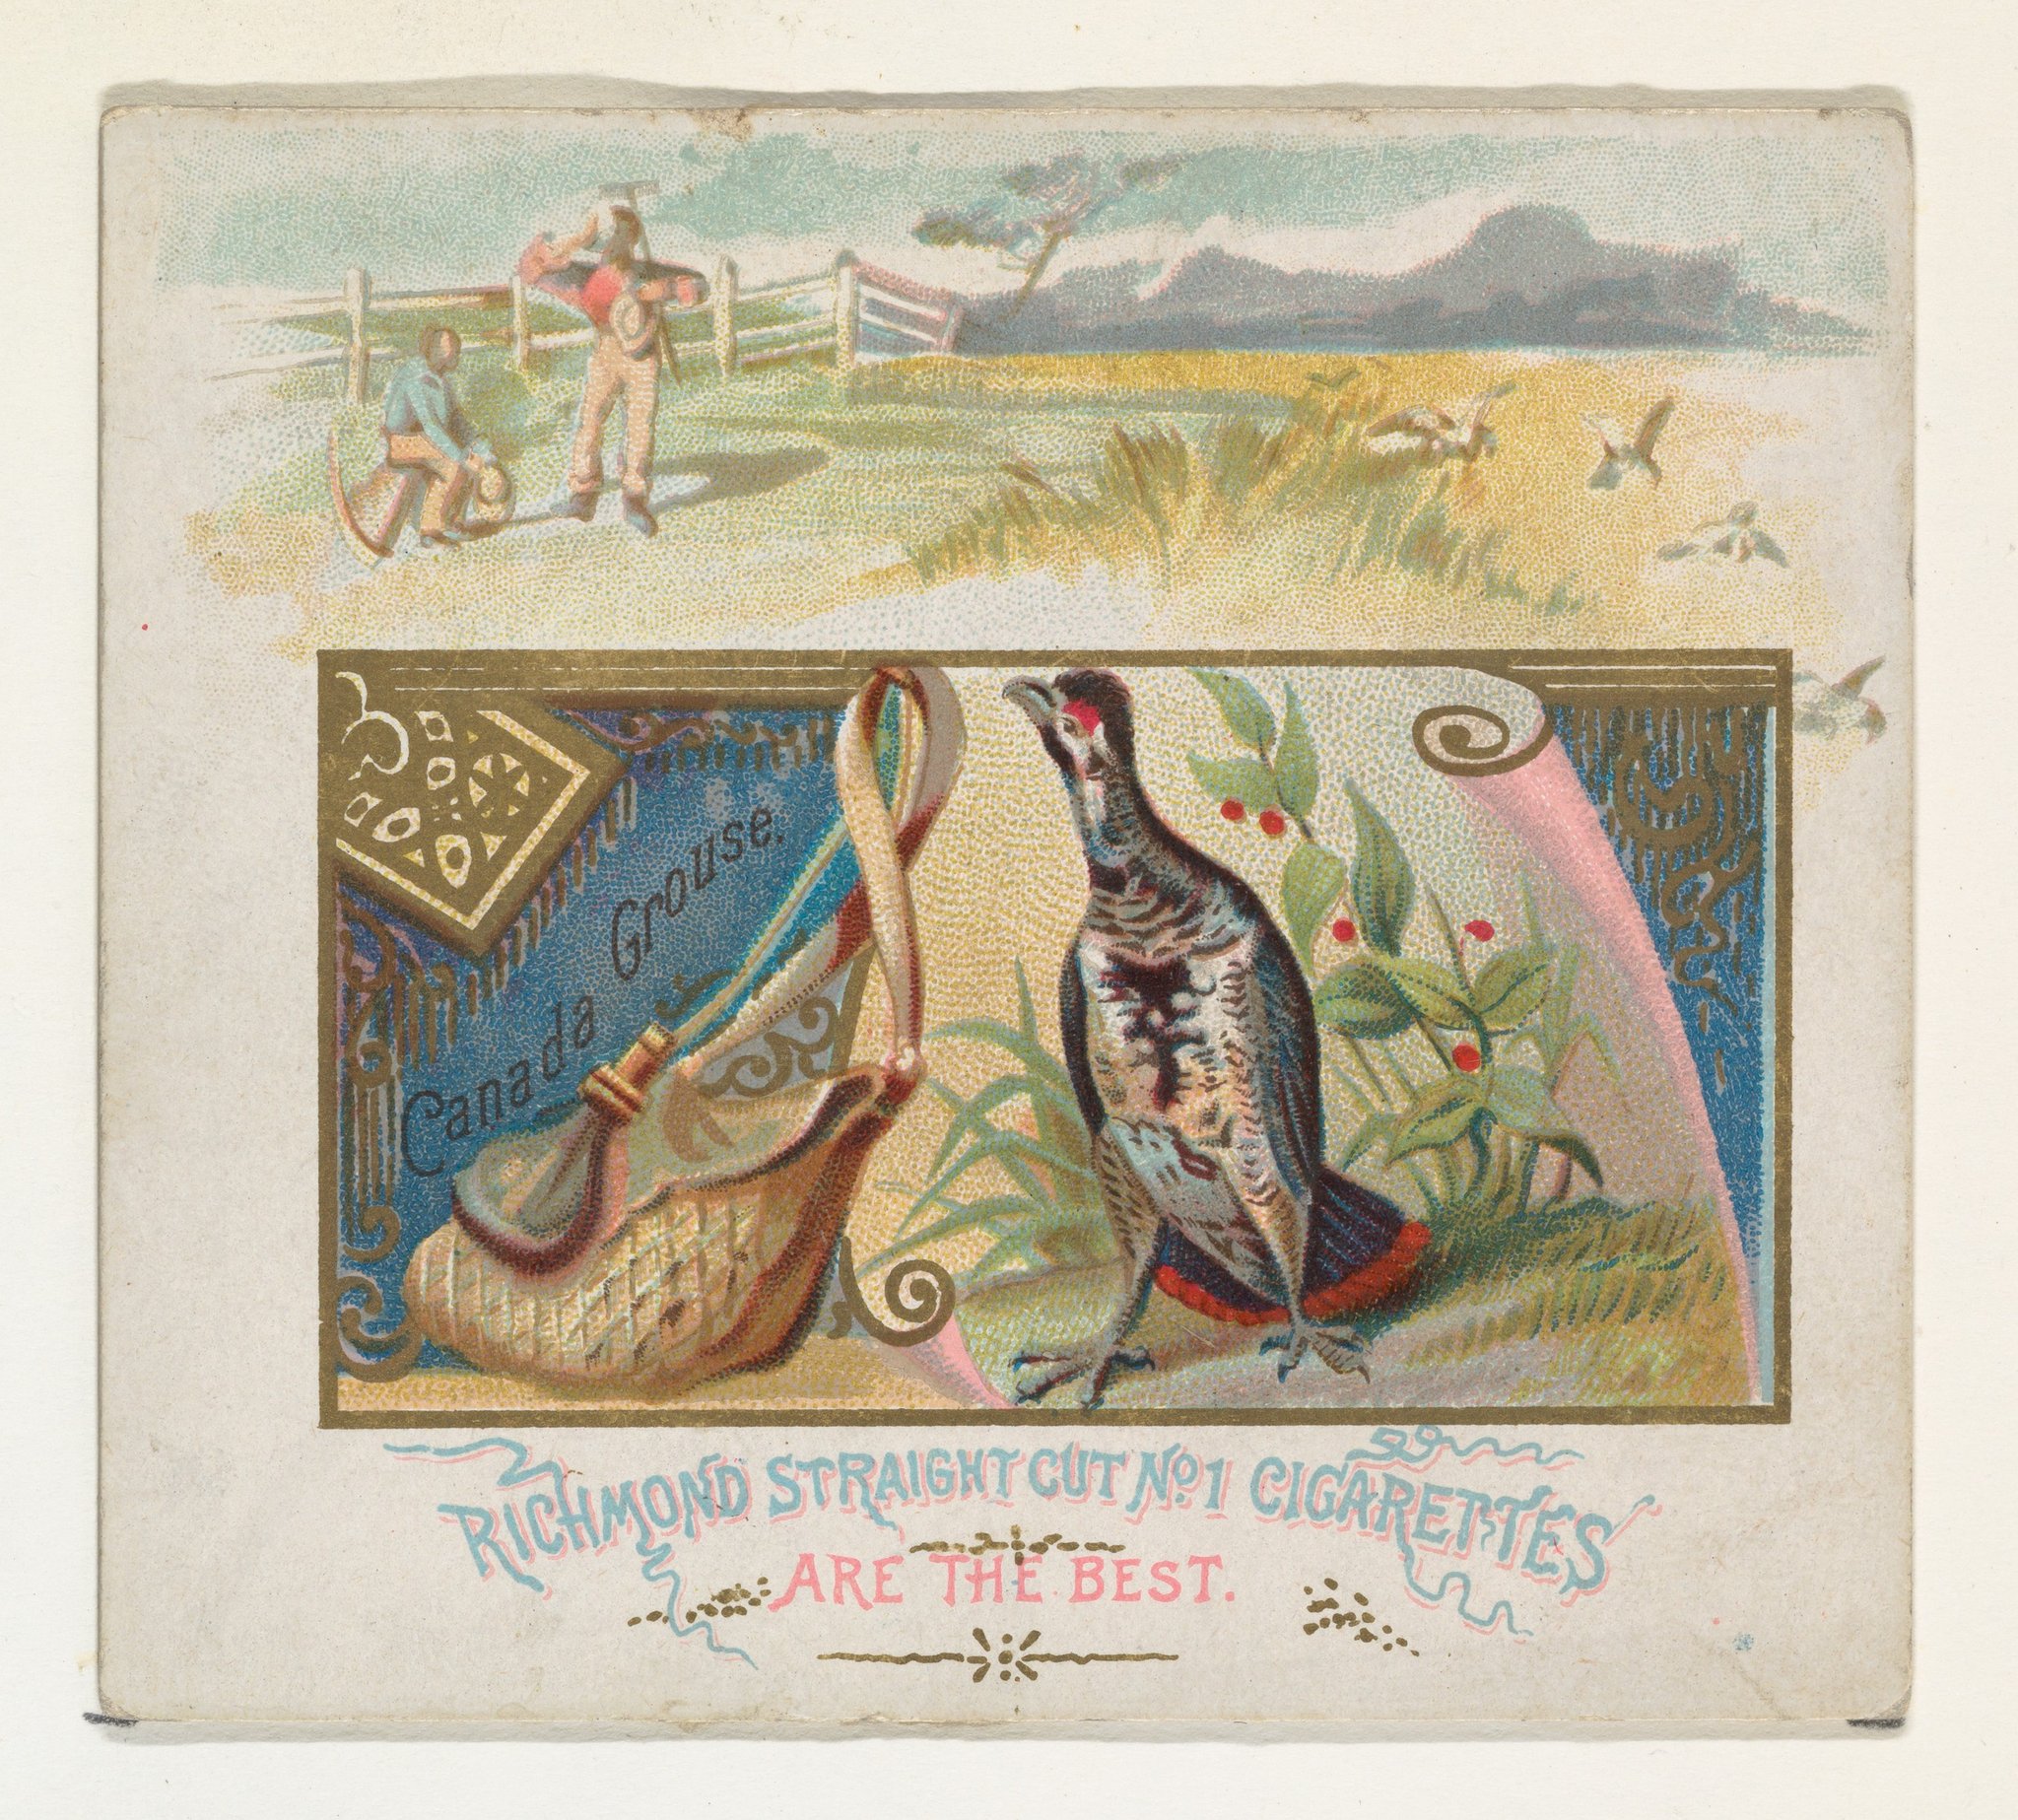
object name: print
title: Canada Grouse, from the Game Birds series (N40) for Allen & Ginter Cigarettes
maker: allen & ginter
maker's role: publisher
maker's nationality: american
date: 1888-1890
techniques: color lithograph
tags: birds